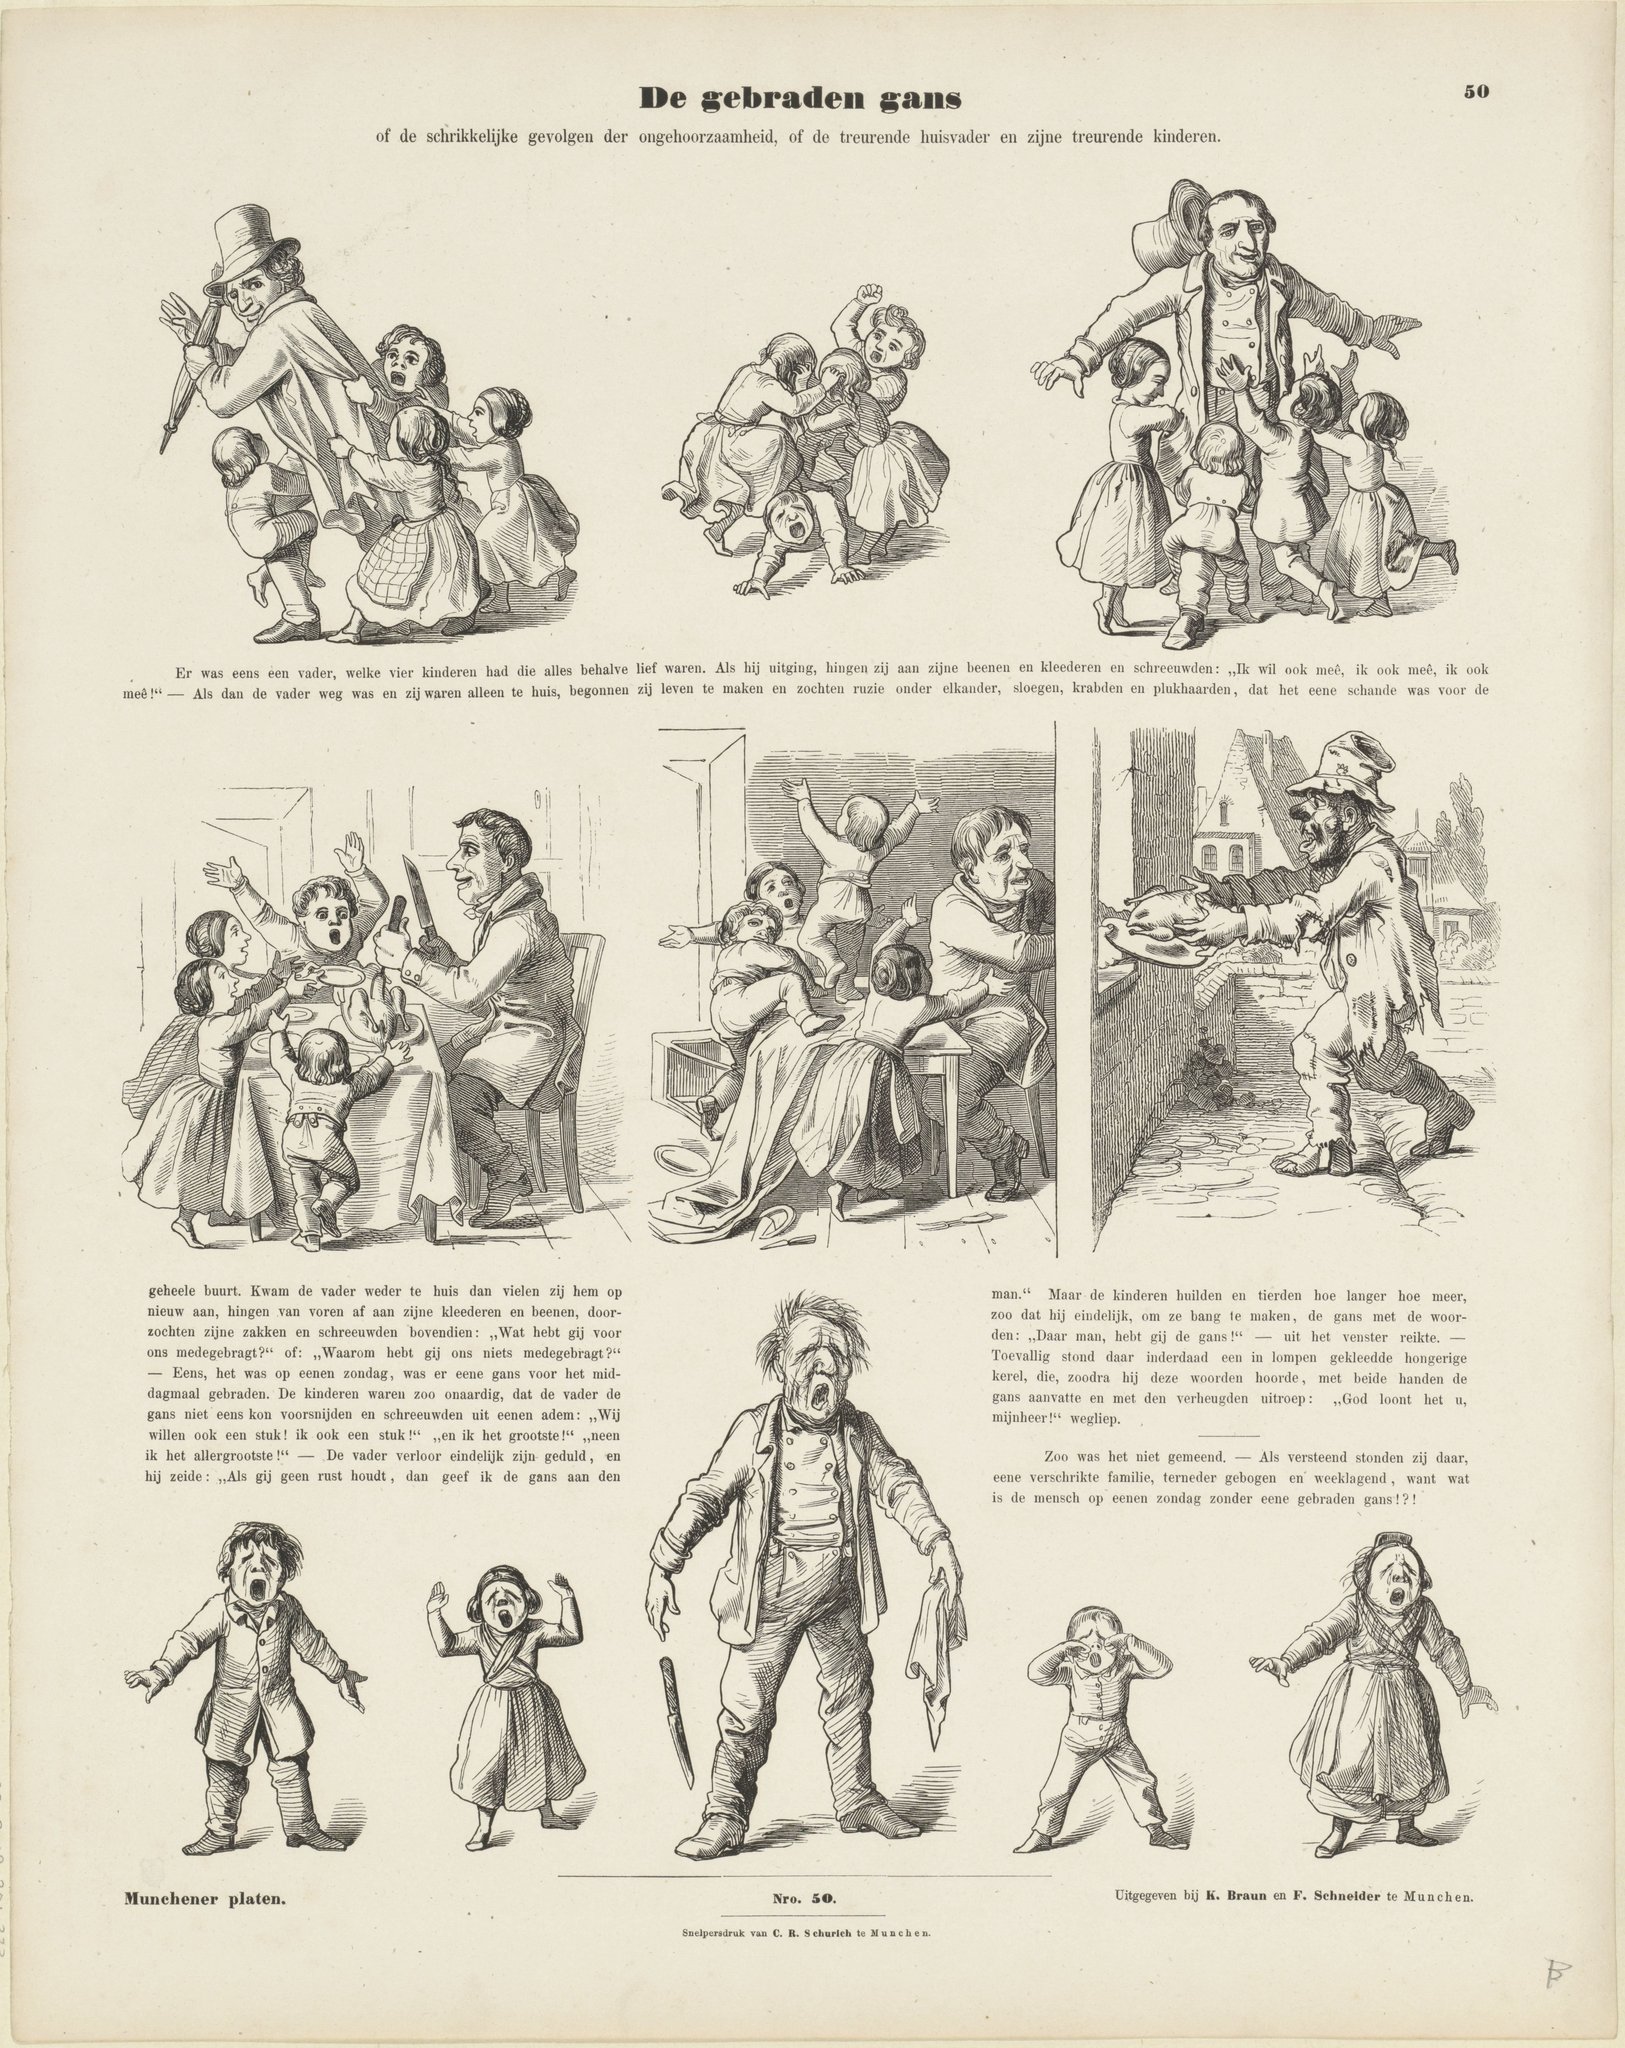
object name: popular print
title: De gebraden gans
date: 1843-1920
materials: paper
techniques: letterpress printing, engraving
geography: munich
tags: hunger, water-birds: goose, father and child(ren), man and child(ren) (family group)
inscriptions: collector's mark: Lugt 2760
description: Blad met 12 voorstellingen uit het verhaal van de gebraden gans. Hoe verwende kinderen een vader radeloos maken en uiteindelijk geen eten hebben. Tekst tussen de afbeeldingen. Genummerd midden onder: Nro. 50. Genummerd rechtsboven: 50.